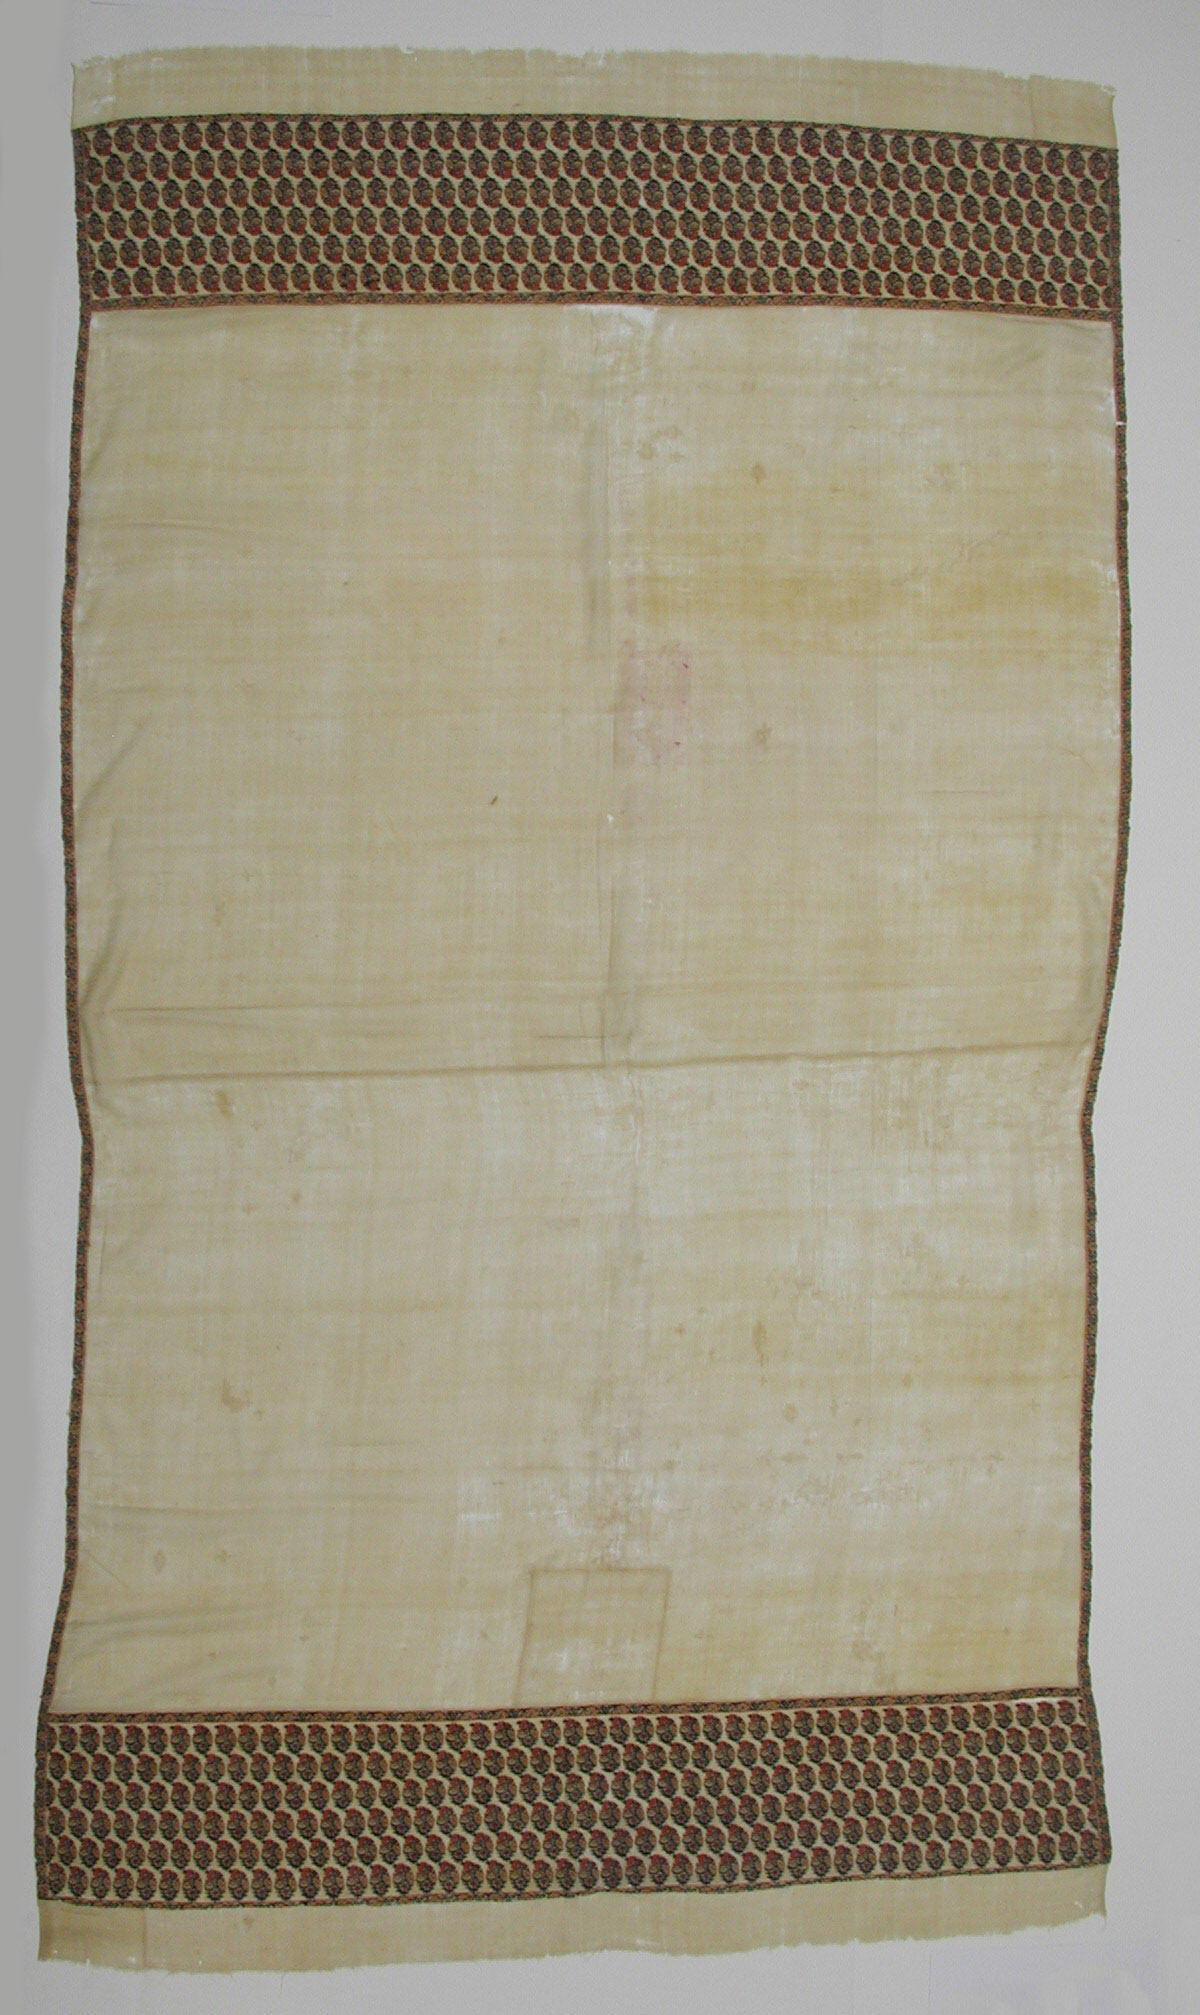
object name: shawl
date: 1801-1833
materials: wool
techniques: interlocking, weave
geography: india